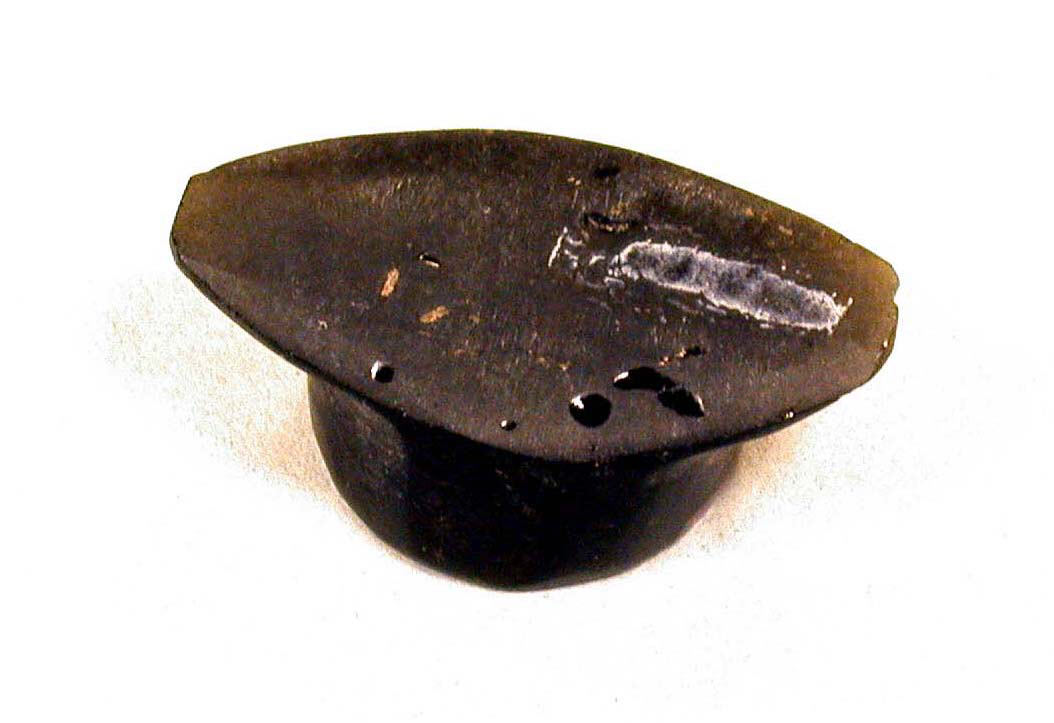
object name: labret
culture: mexican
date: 1501-1600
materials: obsidian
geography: mexico